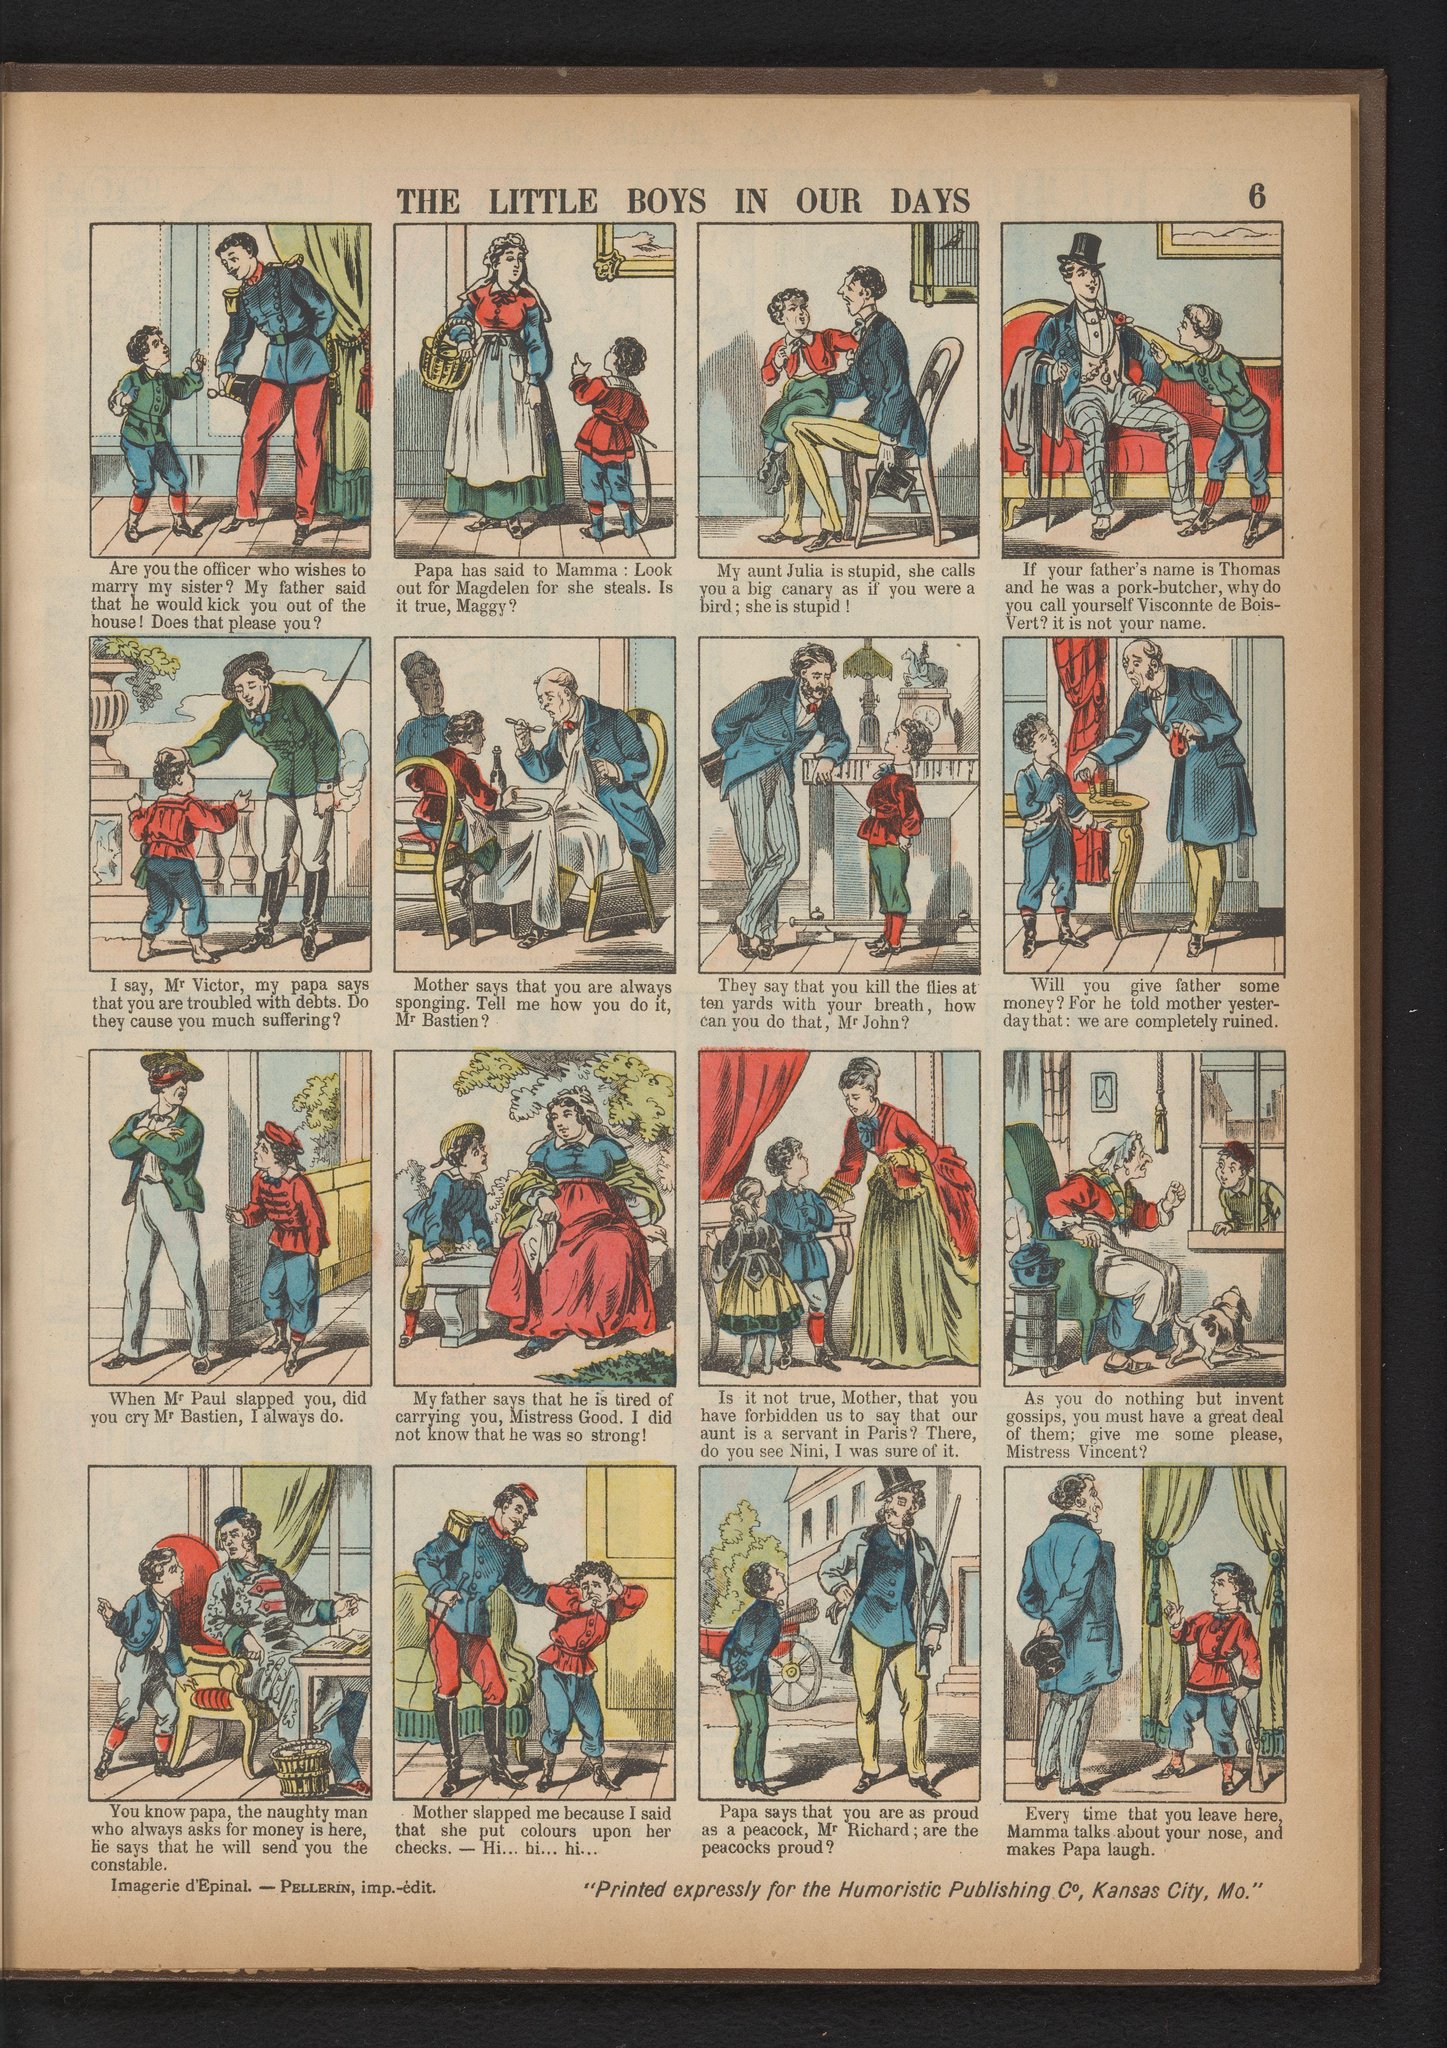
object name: popular print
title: Contes des fées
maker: Anonymous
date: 1893-1894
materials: paper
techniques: colour, letterpress printing, lithograph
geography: kansas city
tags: boy (child between toddler and youth), conversation, dialogue; conversation piece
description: Blad met zestien voorstellingen over een jongen die in diverse situaties de roddels die hij van zijn ouders hoort herhaalt tegen de mensen waarover de roddels gaan. Onder elke voorstelling een onderschrift in het Engels. Deze prent maakt deel uit van een album.